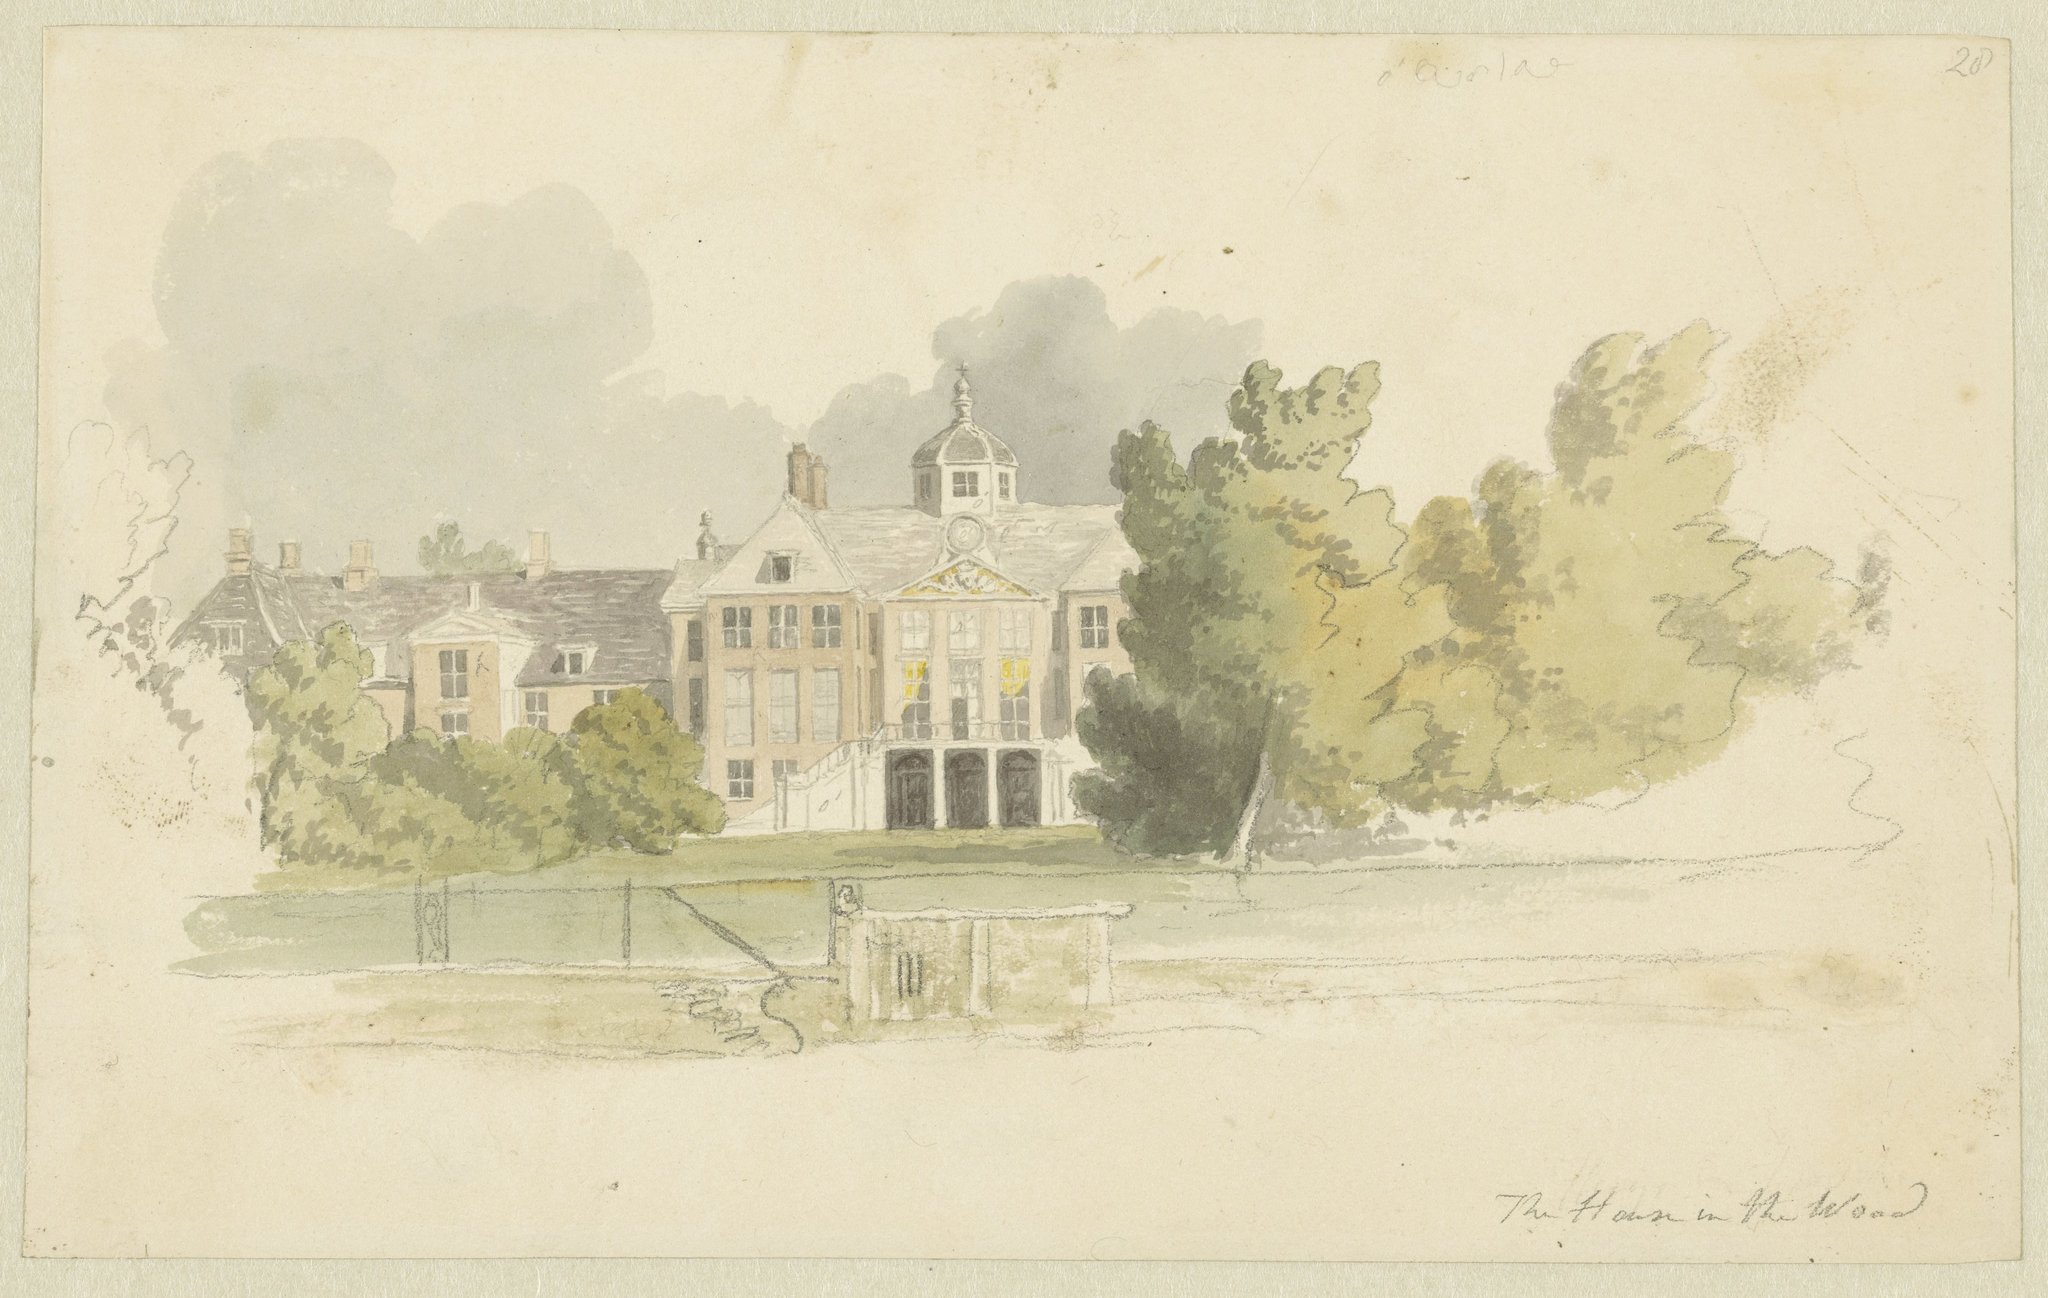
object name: design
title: Gezicht op Huis ten Bosch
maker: robert hills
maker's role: draughtsman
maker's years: 1769-1844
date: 1811-1816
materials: paper, pencil, watercolor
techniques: brush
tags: palace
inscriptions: inscription: ‘The House in the wood’